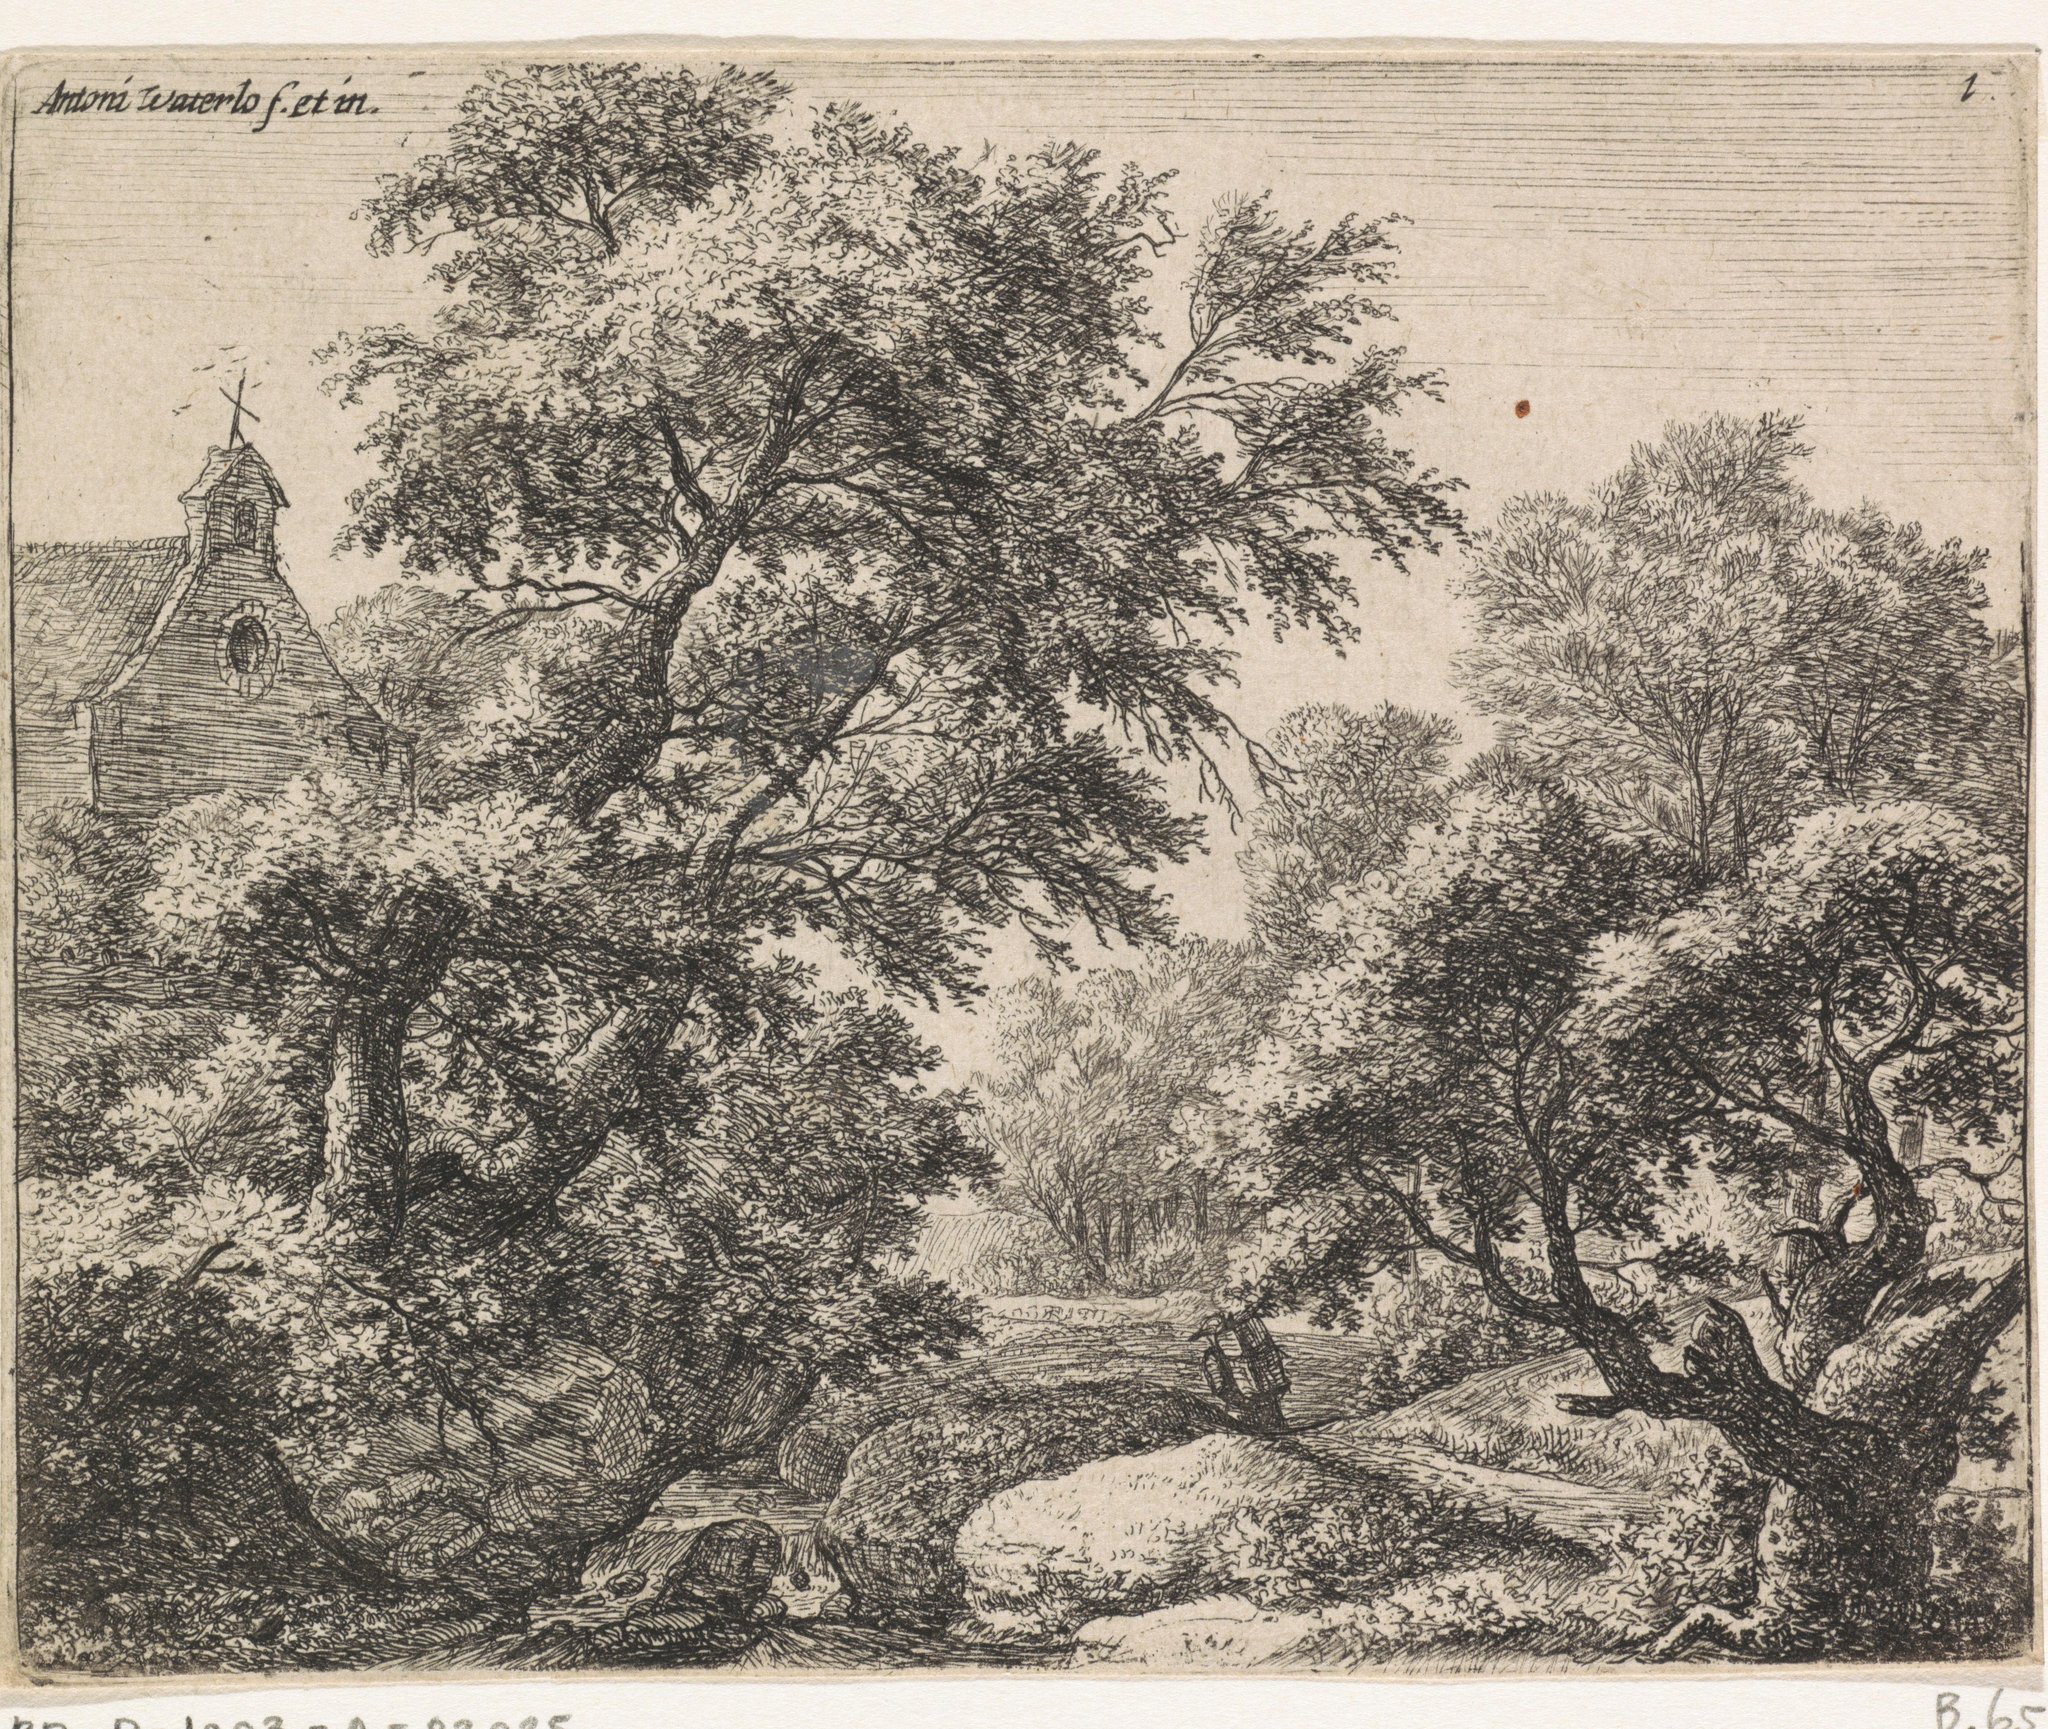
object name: print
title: Bosgezichten, serie B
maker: anthonie waterloo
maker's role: draughtsman, painter, print maker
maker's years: 1609-1690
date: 1630-1663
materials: paper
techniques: etching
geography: amsterdam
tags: pedlar, forest, wood, brook, church (exterior) - qq - small church, chapel, landscapes (+ landscape with figures, staffage)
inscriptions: collector's mark: Lugt 2612, collector's mark: Lugt 2228, collector's mark: Lugt 567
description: Links ligt een kleine kerk of kapel aan de oever van een beek. Rechts loopt een marskramer over een bospad.